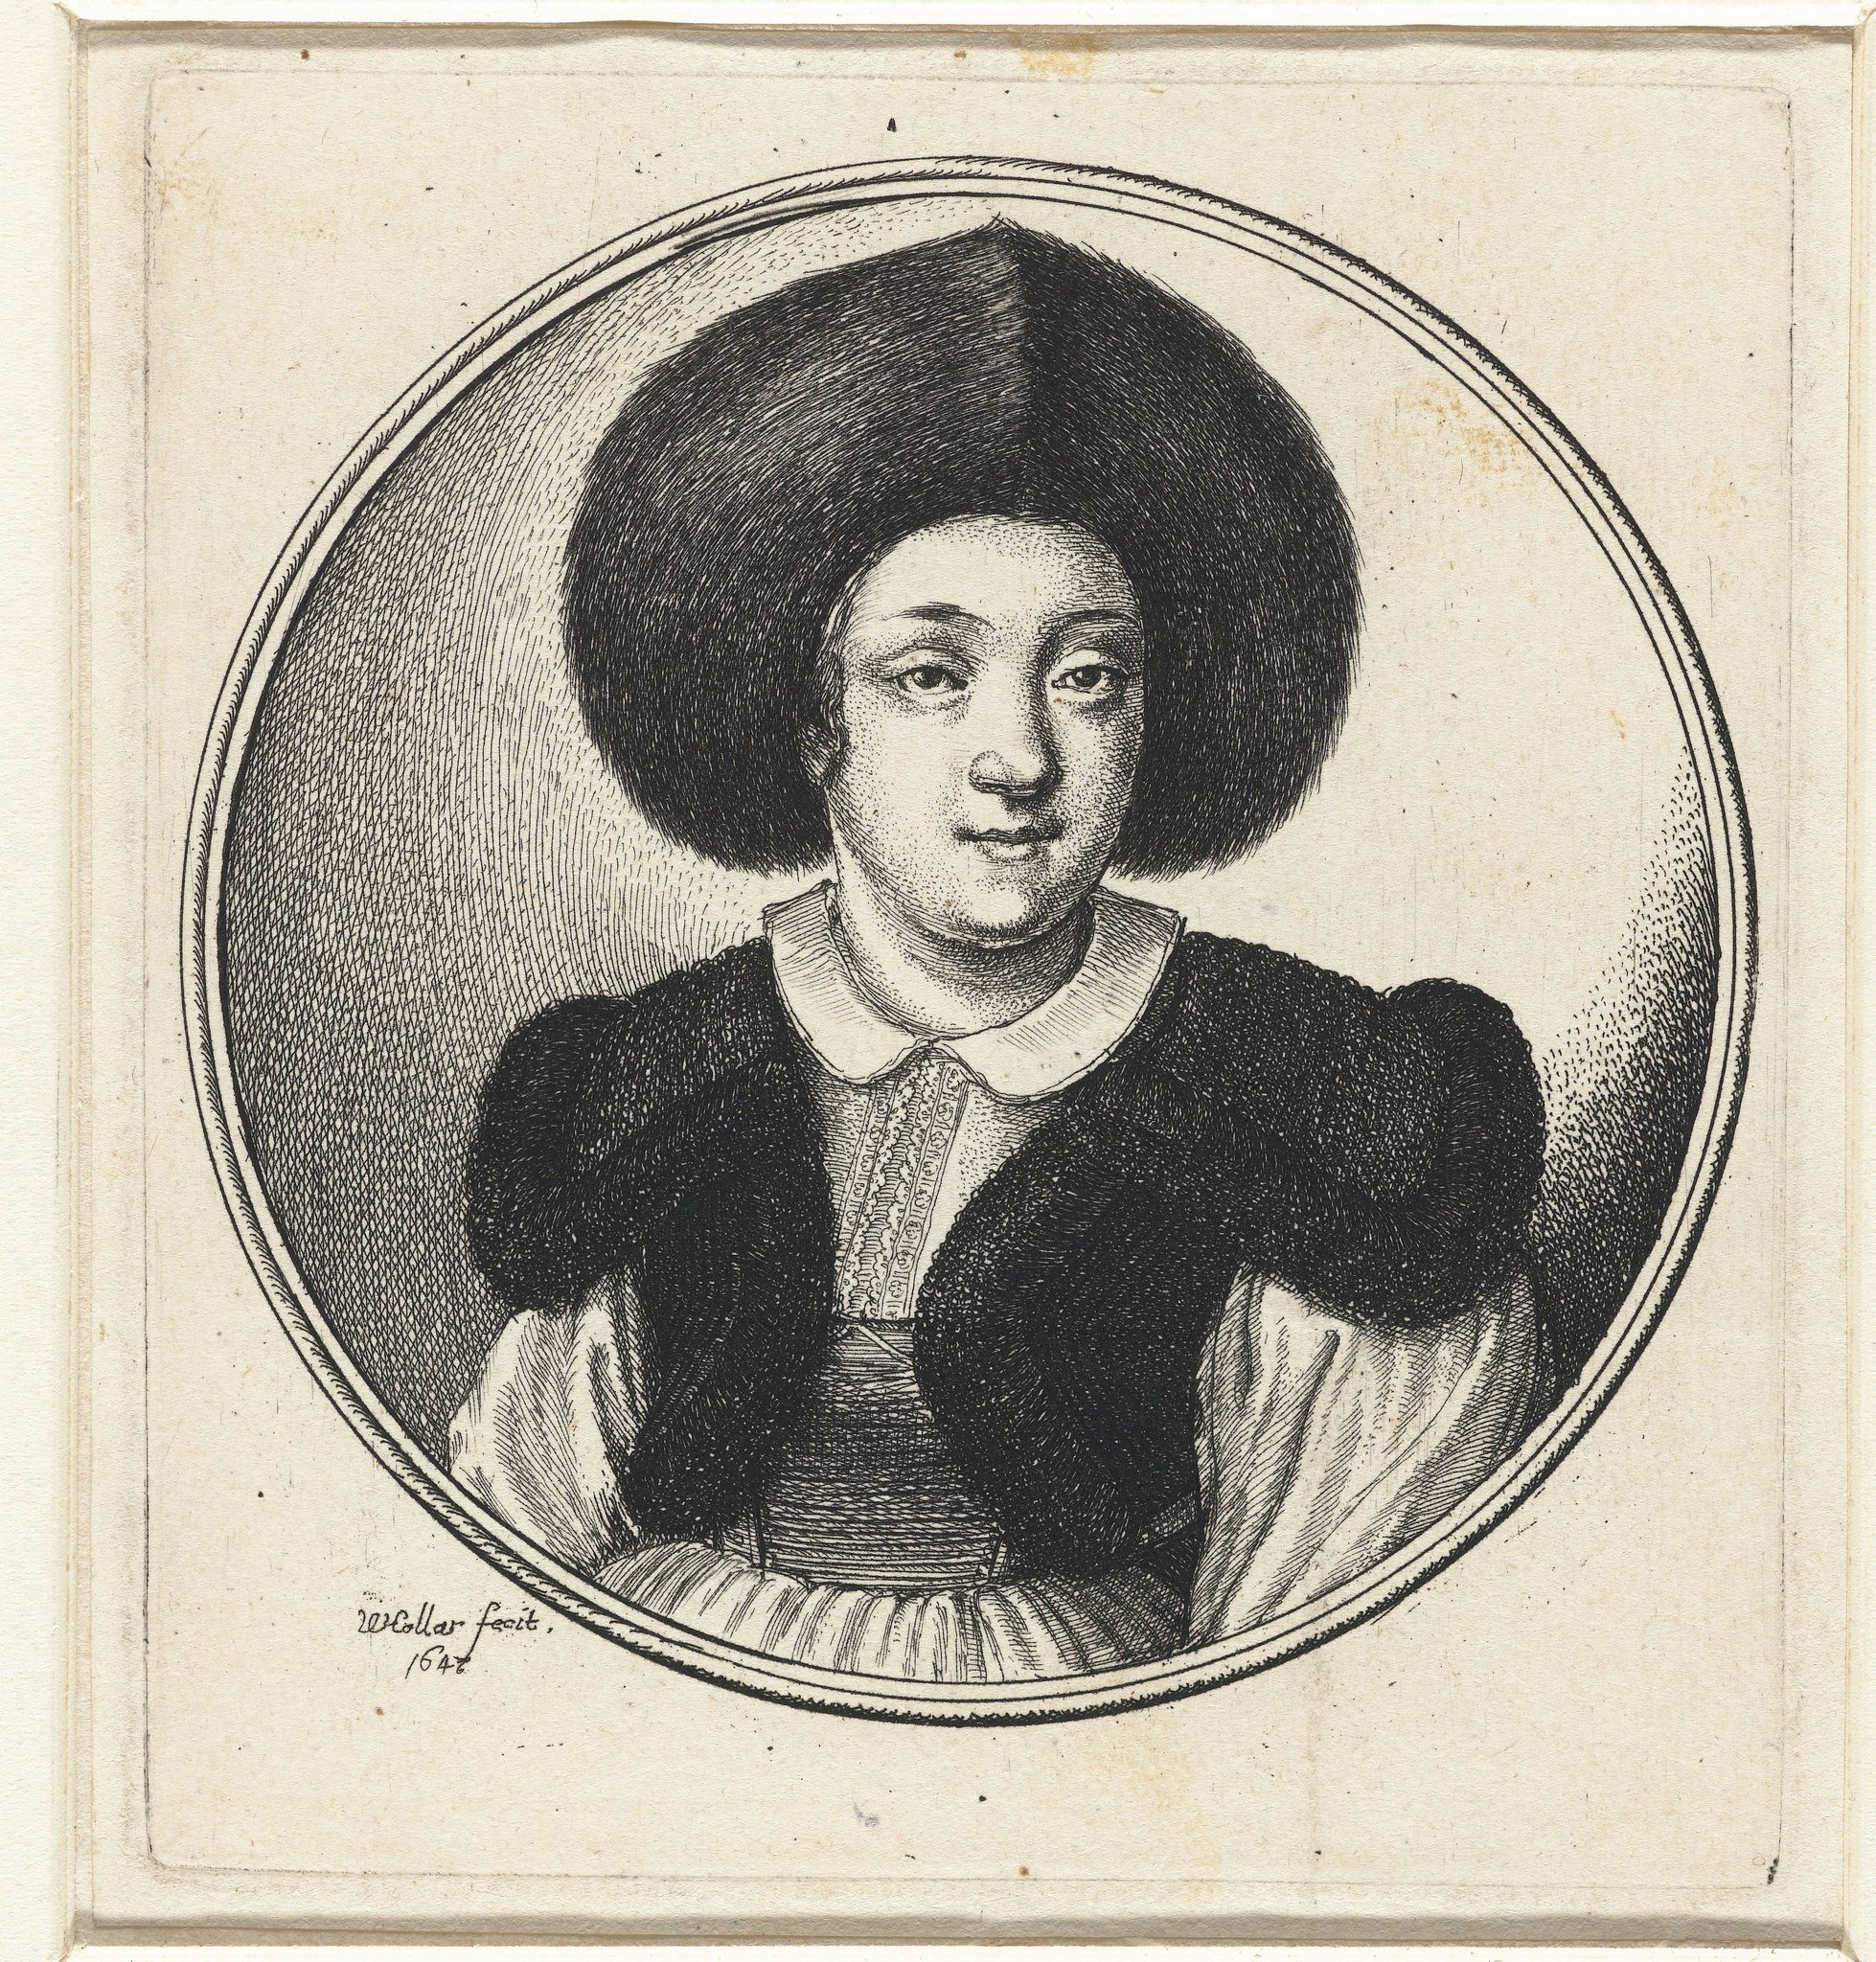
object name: print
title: Vrouwenbusten in ronde lijsten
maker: wenceslaus hollar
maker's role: draughtsman, print maker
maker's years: 1607-1677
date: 1647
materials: paper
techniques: etching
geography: antwerp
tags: clothing for the upper part of the body (bodice) (+ fur used for clothes), anonymous historical person portrayed alone - bb - woman, head-gear: cap (+ women's clothes), clothing for the upper part of the body (with name) (+ women's clothes), head-gear: cap (+ fur used for clothes)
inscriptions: collector's mark: Lugt 654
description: De prent maakt deel uit van een 23-delige serie met verschillende vrouwenbusten in ronde lijsten.